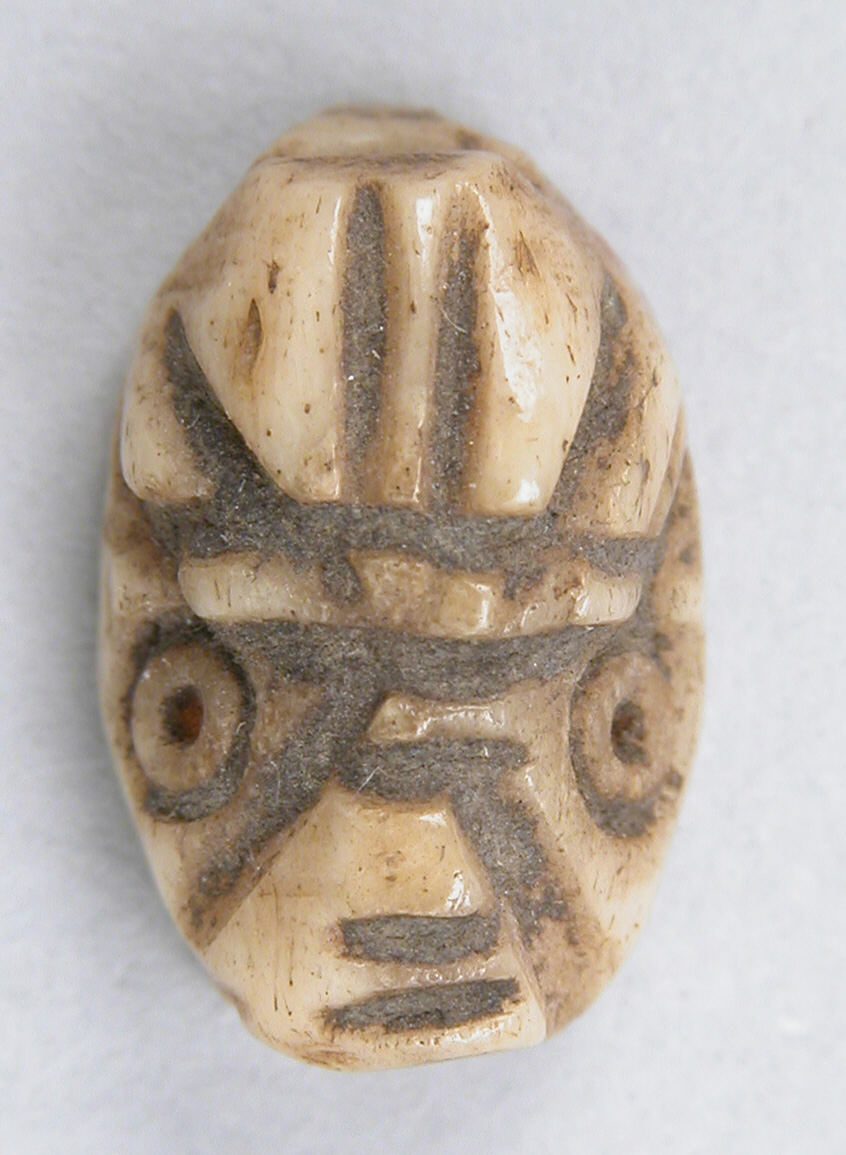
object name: plaque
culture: coptic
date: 301-700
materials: bone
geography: egypt